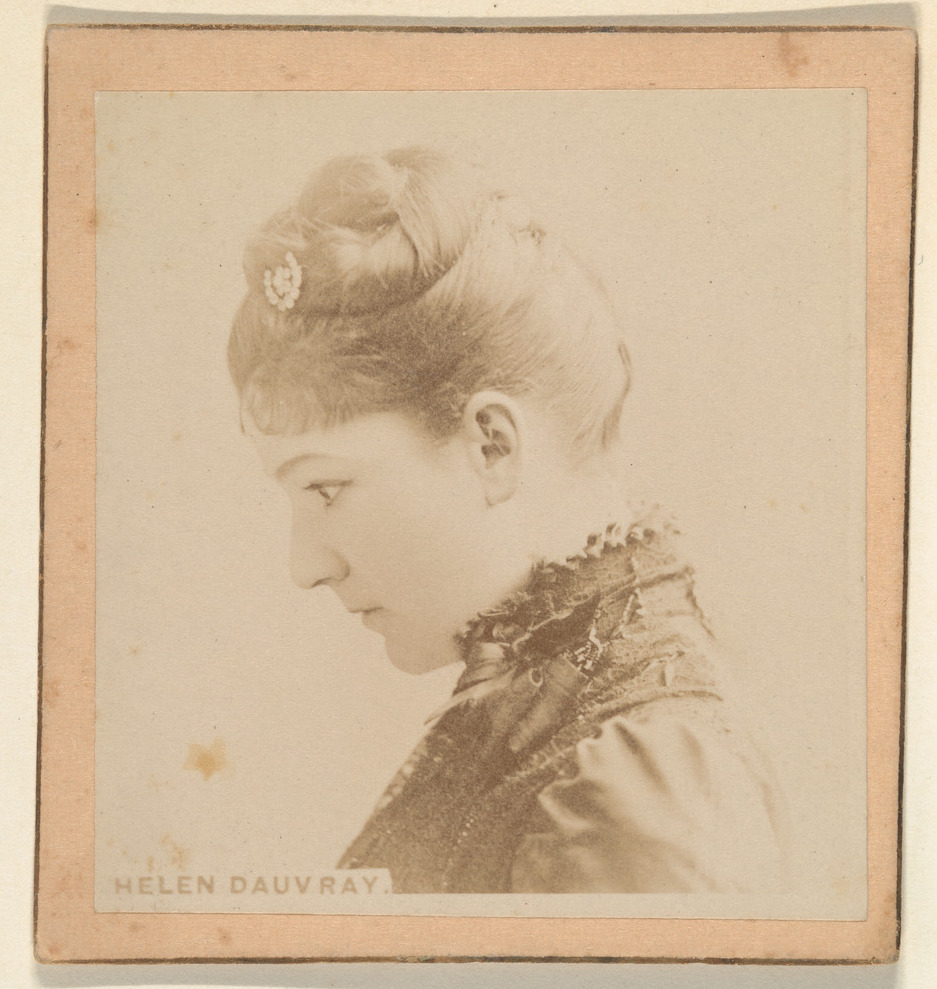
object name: photograph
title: Helen Dauvray, from the Actresses series (N246), Type 2, issued by Kinney Brothers to promote Sporting Extra Cigarettes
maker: kinney brothers tobacco company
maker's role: publisher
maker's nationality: american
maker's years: 1869-2011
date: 1890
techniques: albumen silver print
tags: women,actresses